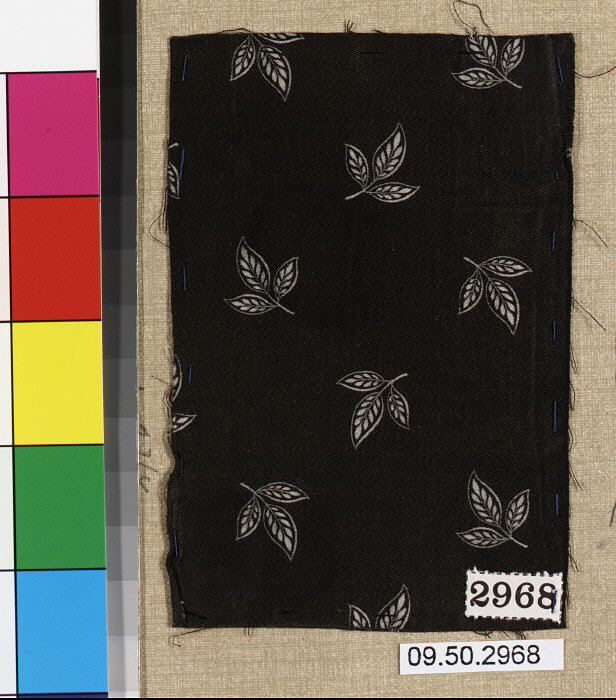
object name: piece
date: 1801-1900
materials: cotton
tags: leaves